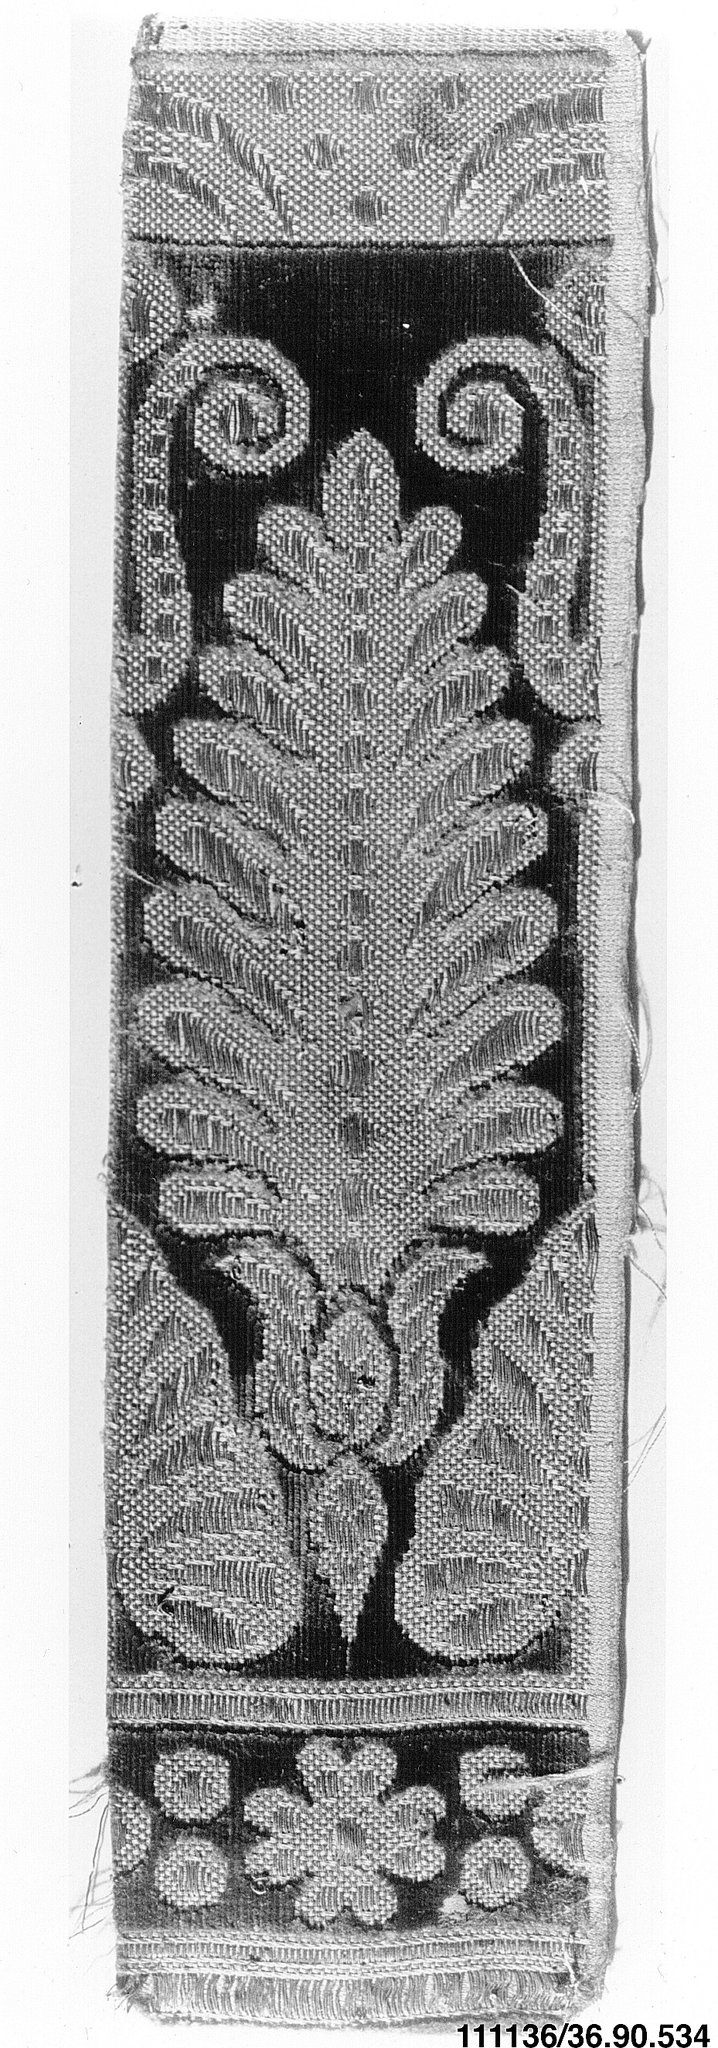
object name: piece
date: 1801-1833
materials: metal thread, silk